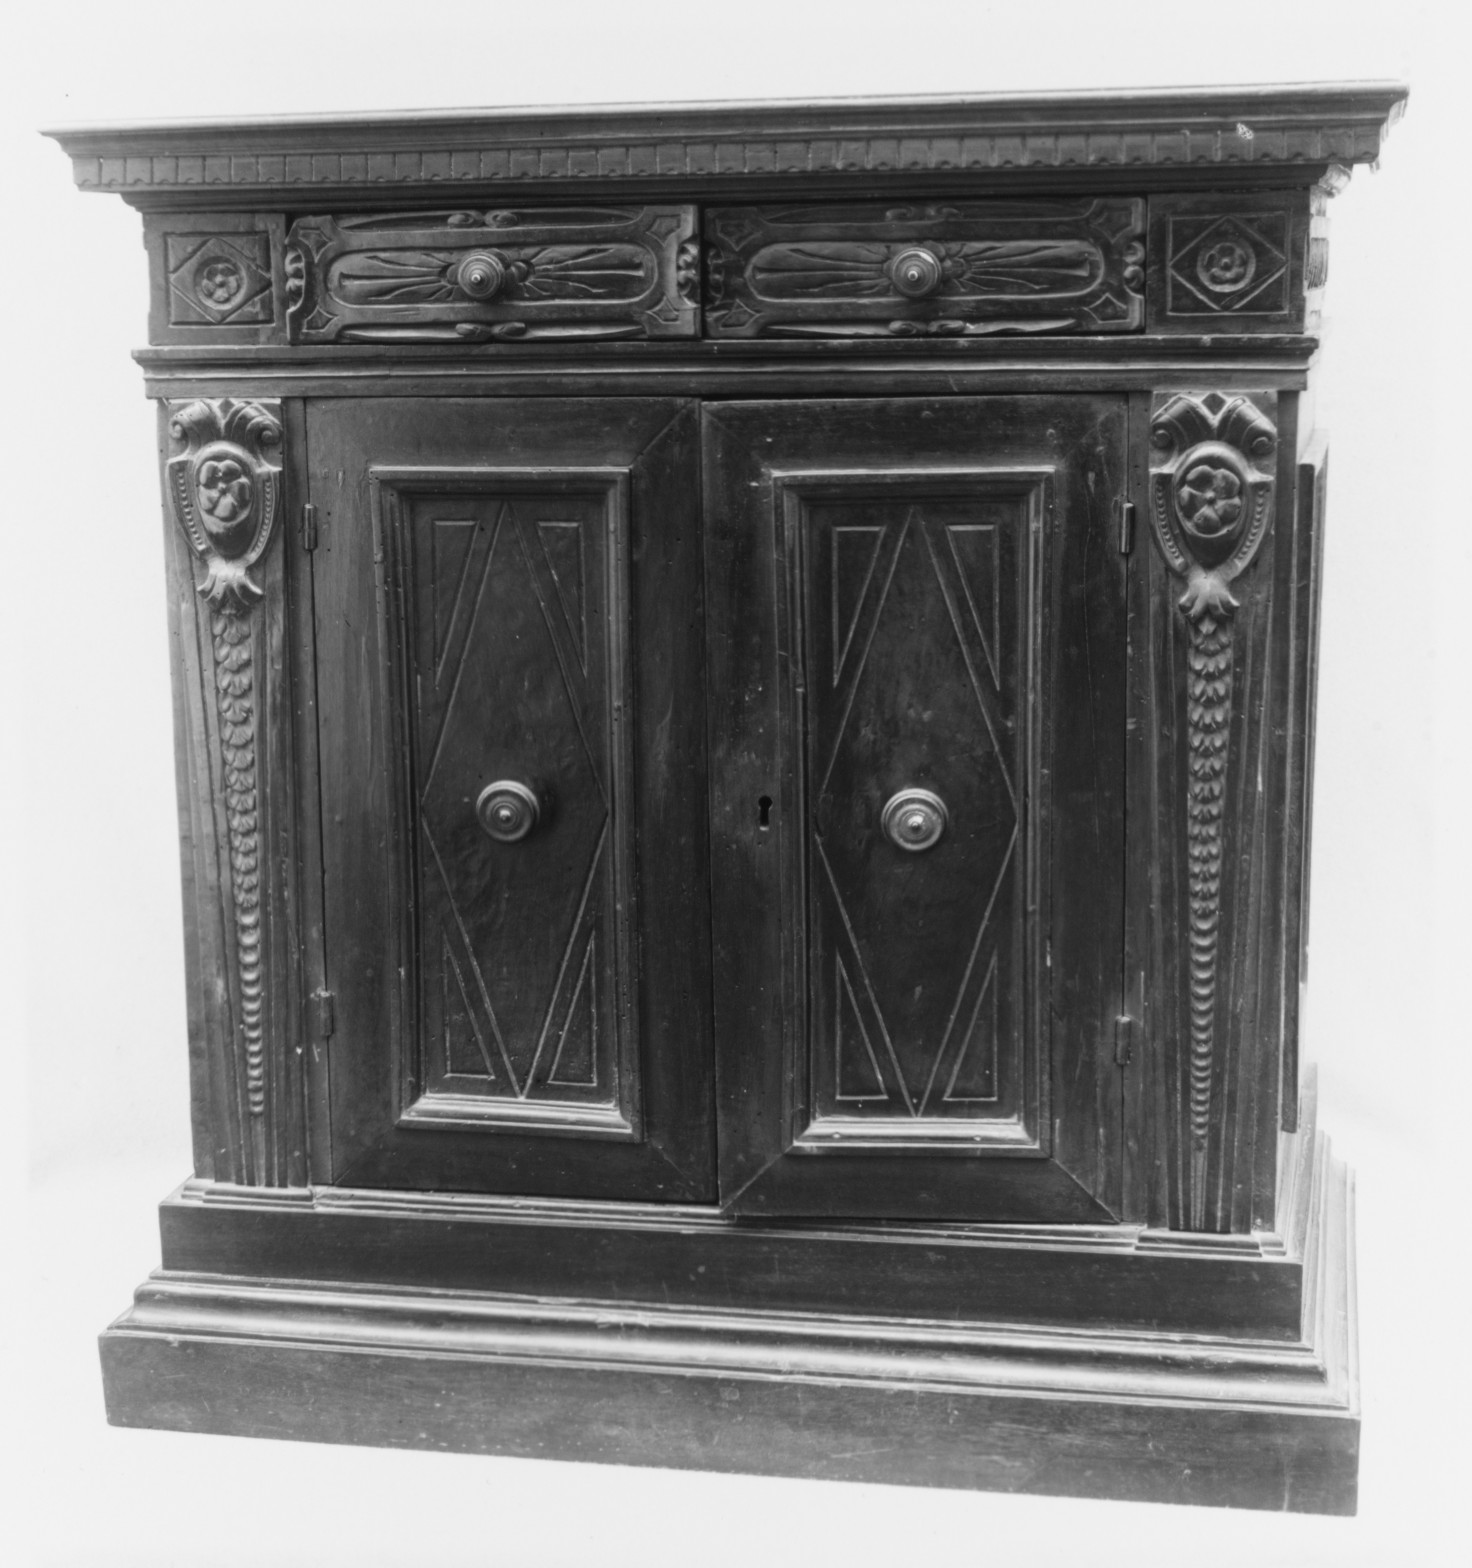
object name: cabinet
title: Cabinet (credenza)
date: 1551-1600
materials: wood